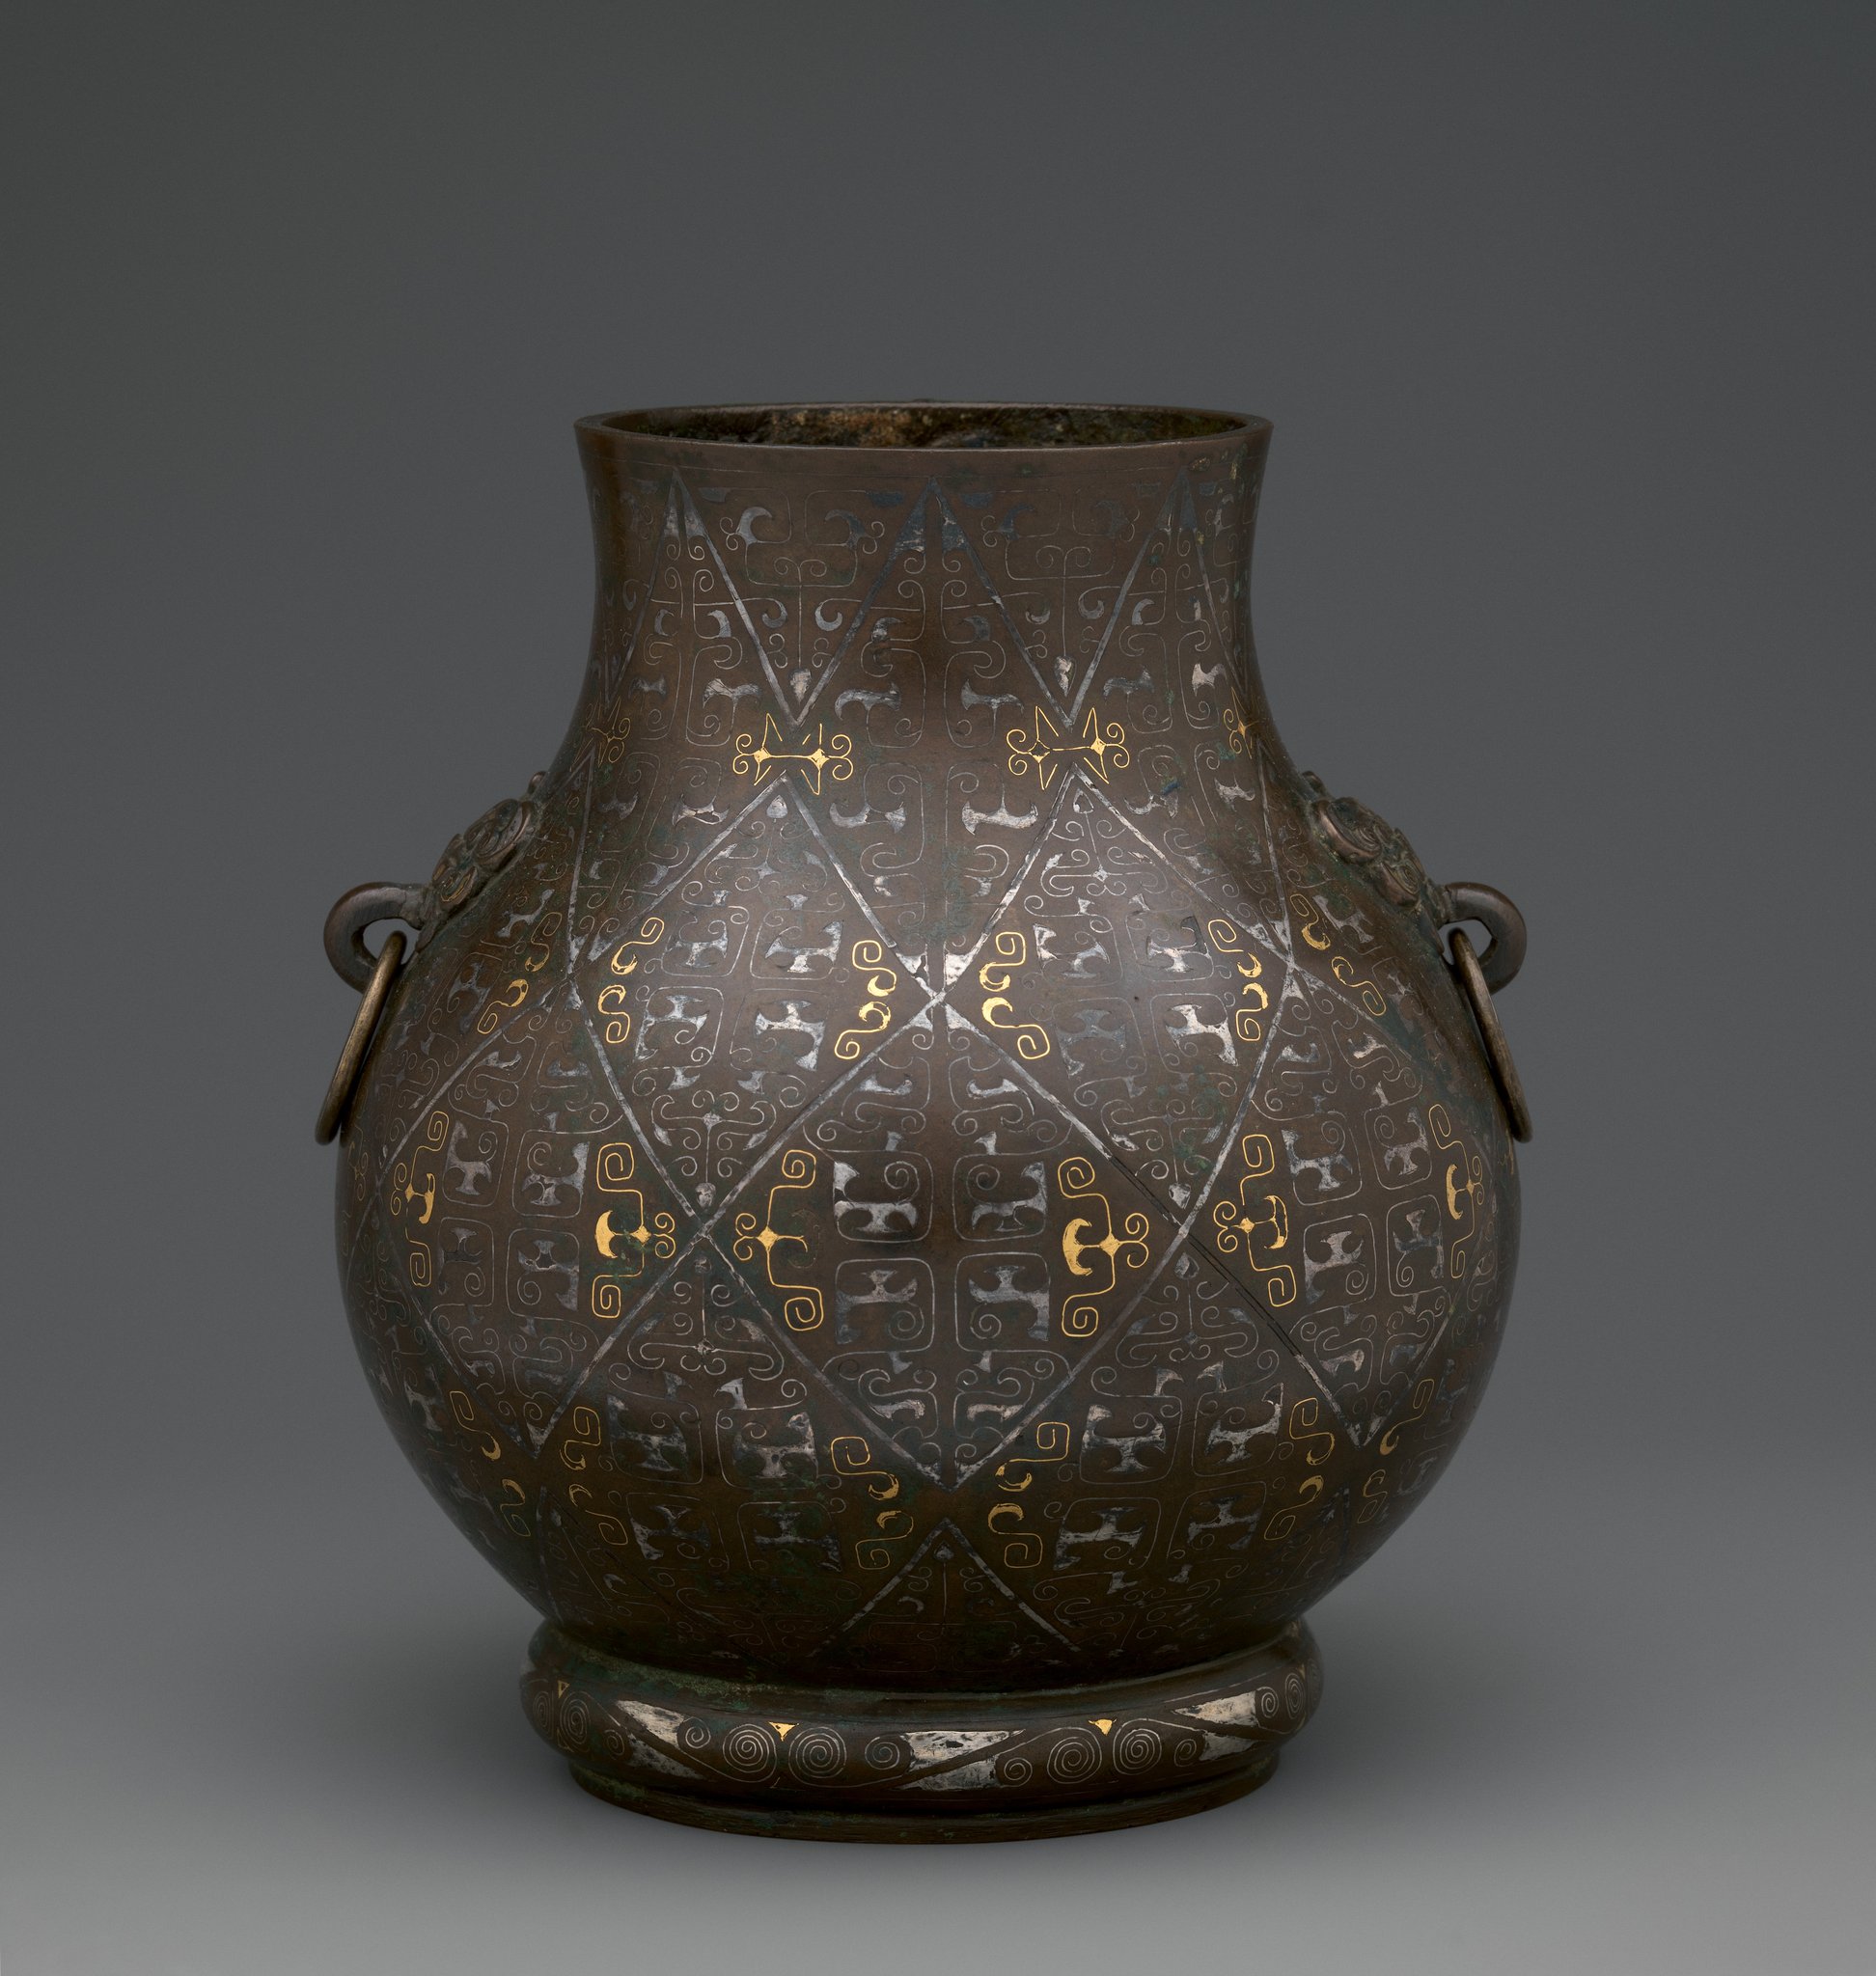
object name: vase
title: Archaic-style Vase (hu)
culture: chinese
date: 1401-1600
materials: copper alloy, gold, silver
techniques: inlay